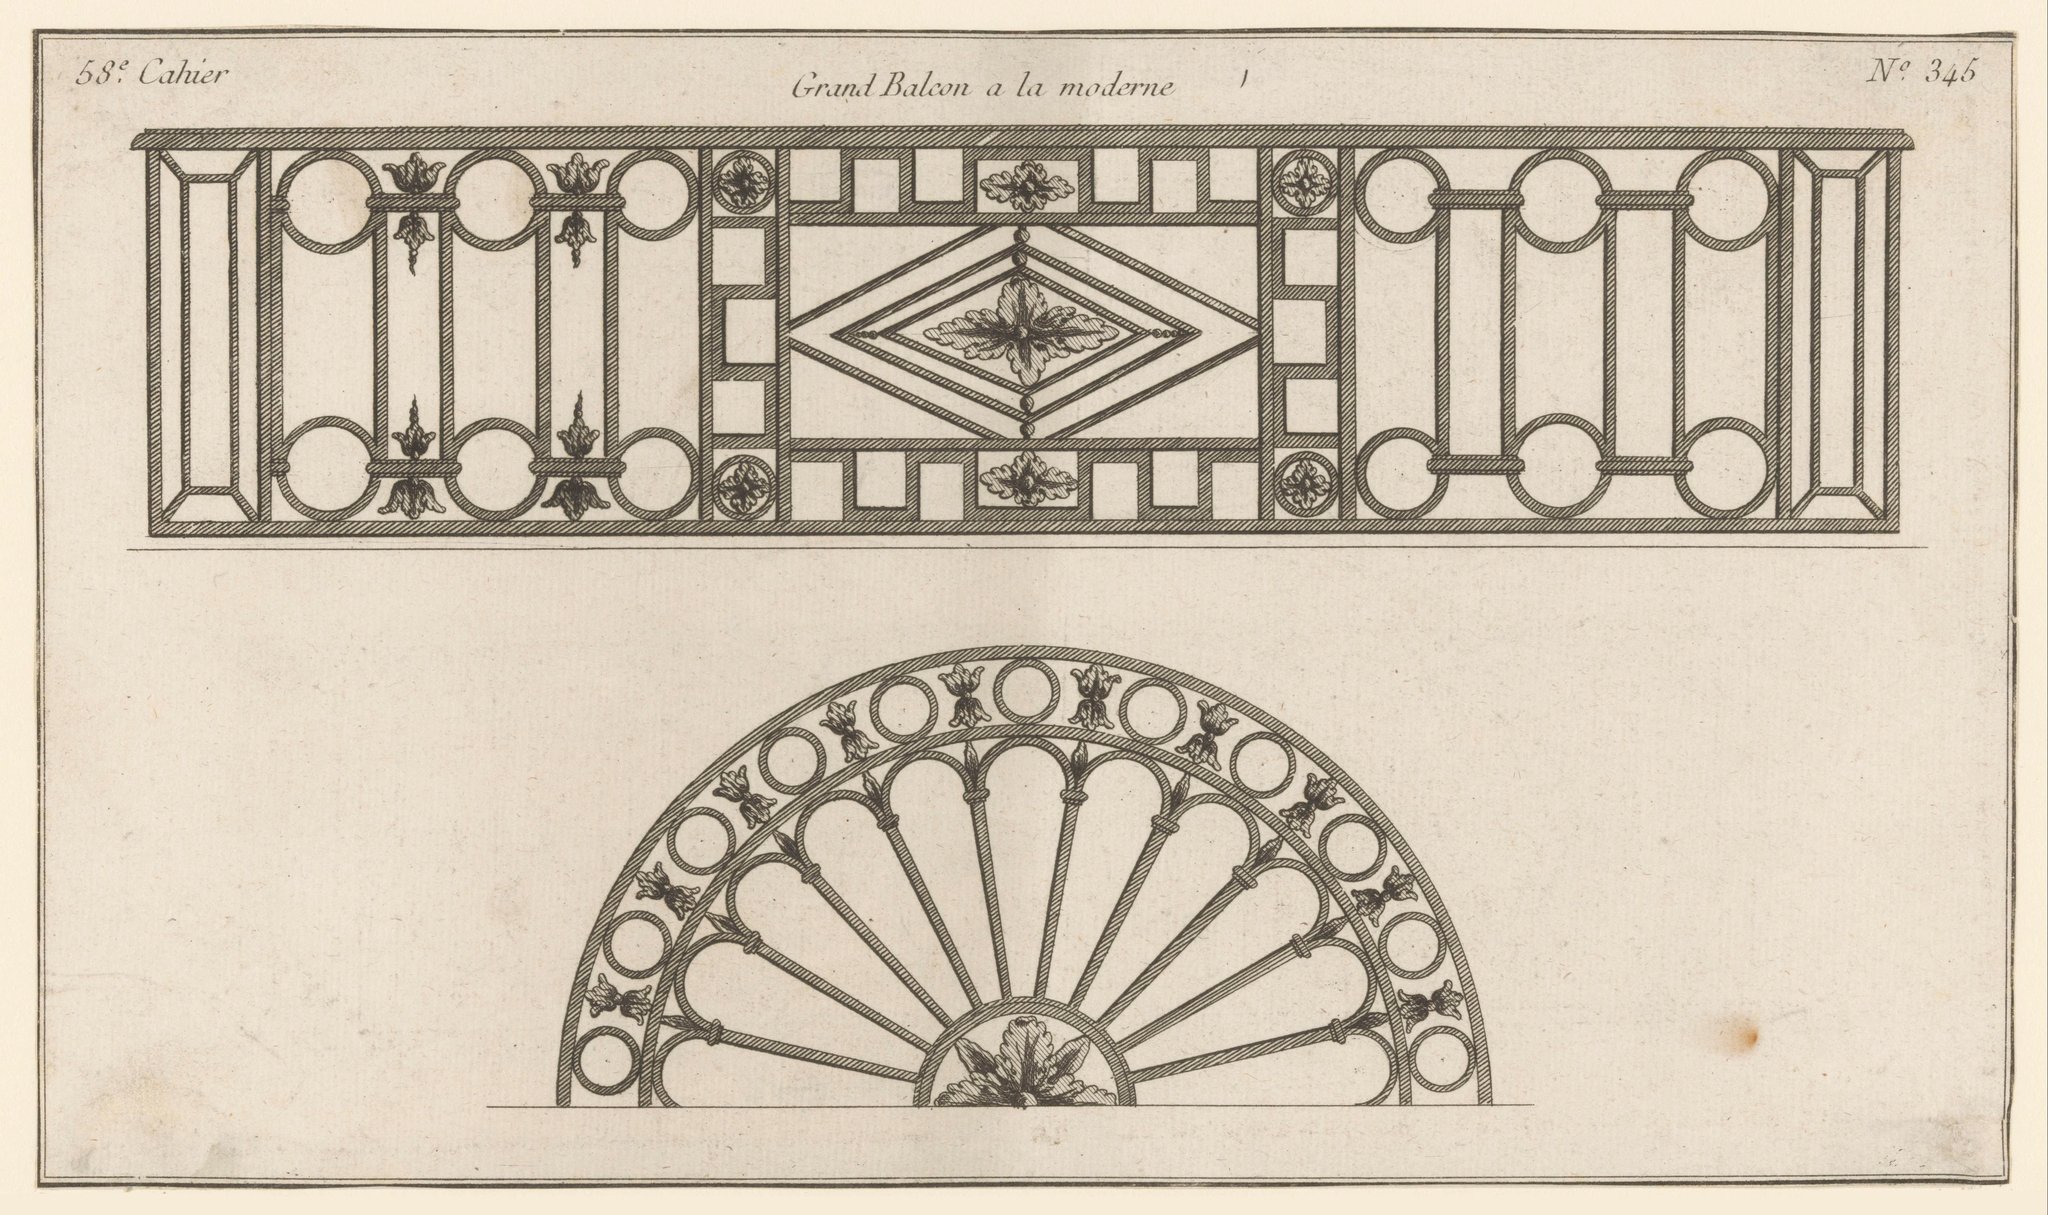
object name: print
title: Balkonhekken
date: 1772-1779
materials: paper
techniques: engraving, etching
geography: paris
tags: balcony, flowers ~ ornament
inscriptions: collector's mark: Lugt 2228, collector's mark: Lugt 2760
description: Twee smeedijzeren balkonhekken met bloemmotieven, het onderste hek is halfrond. Prentnummer 345.